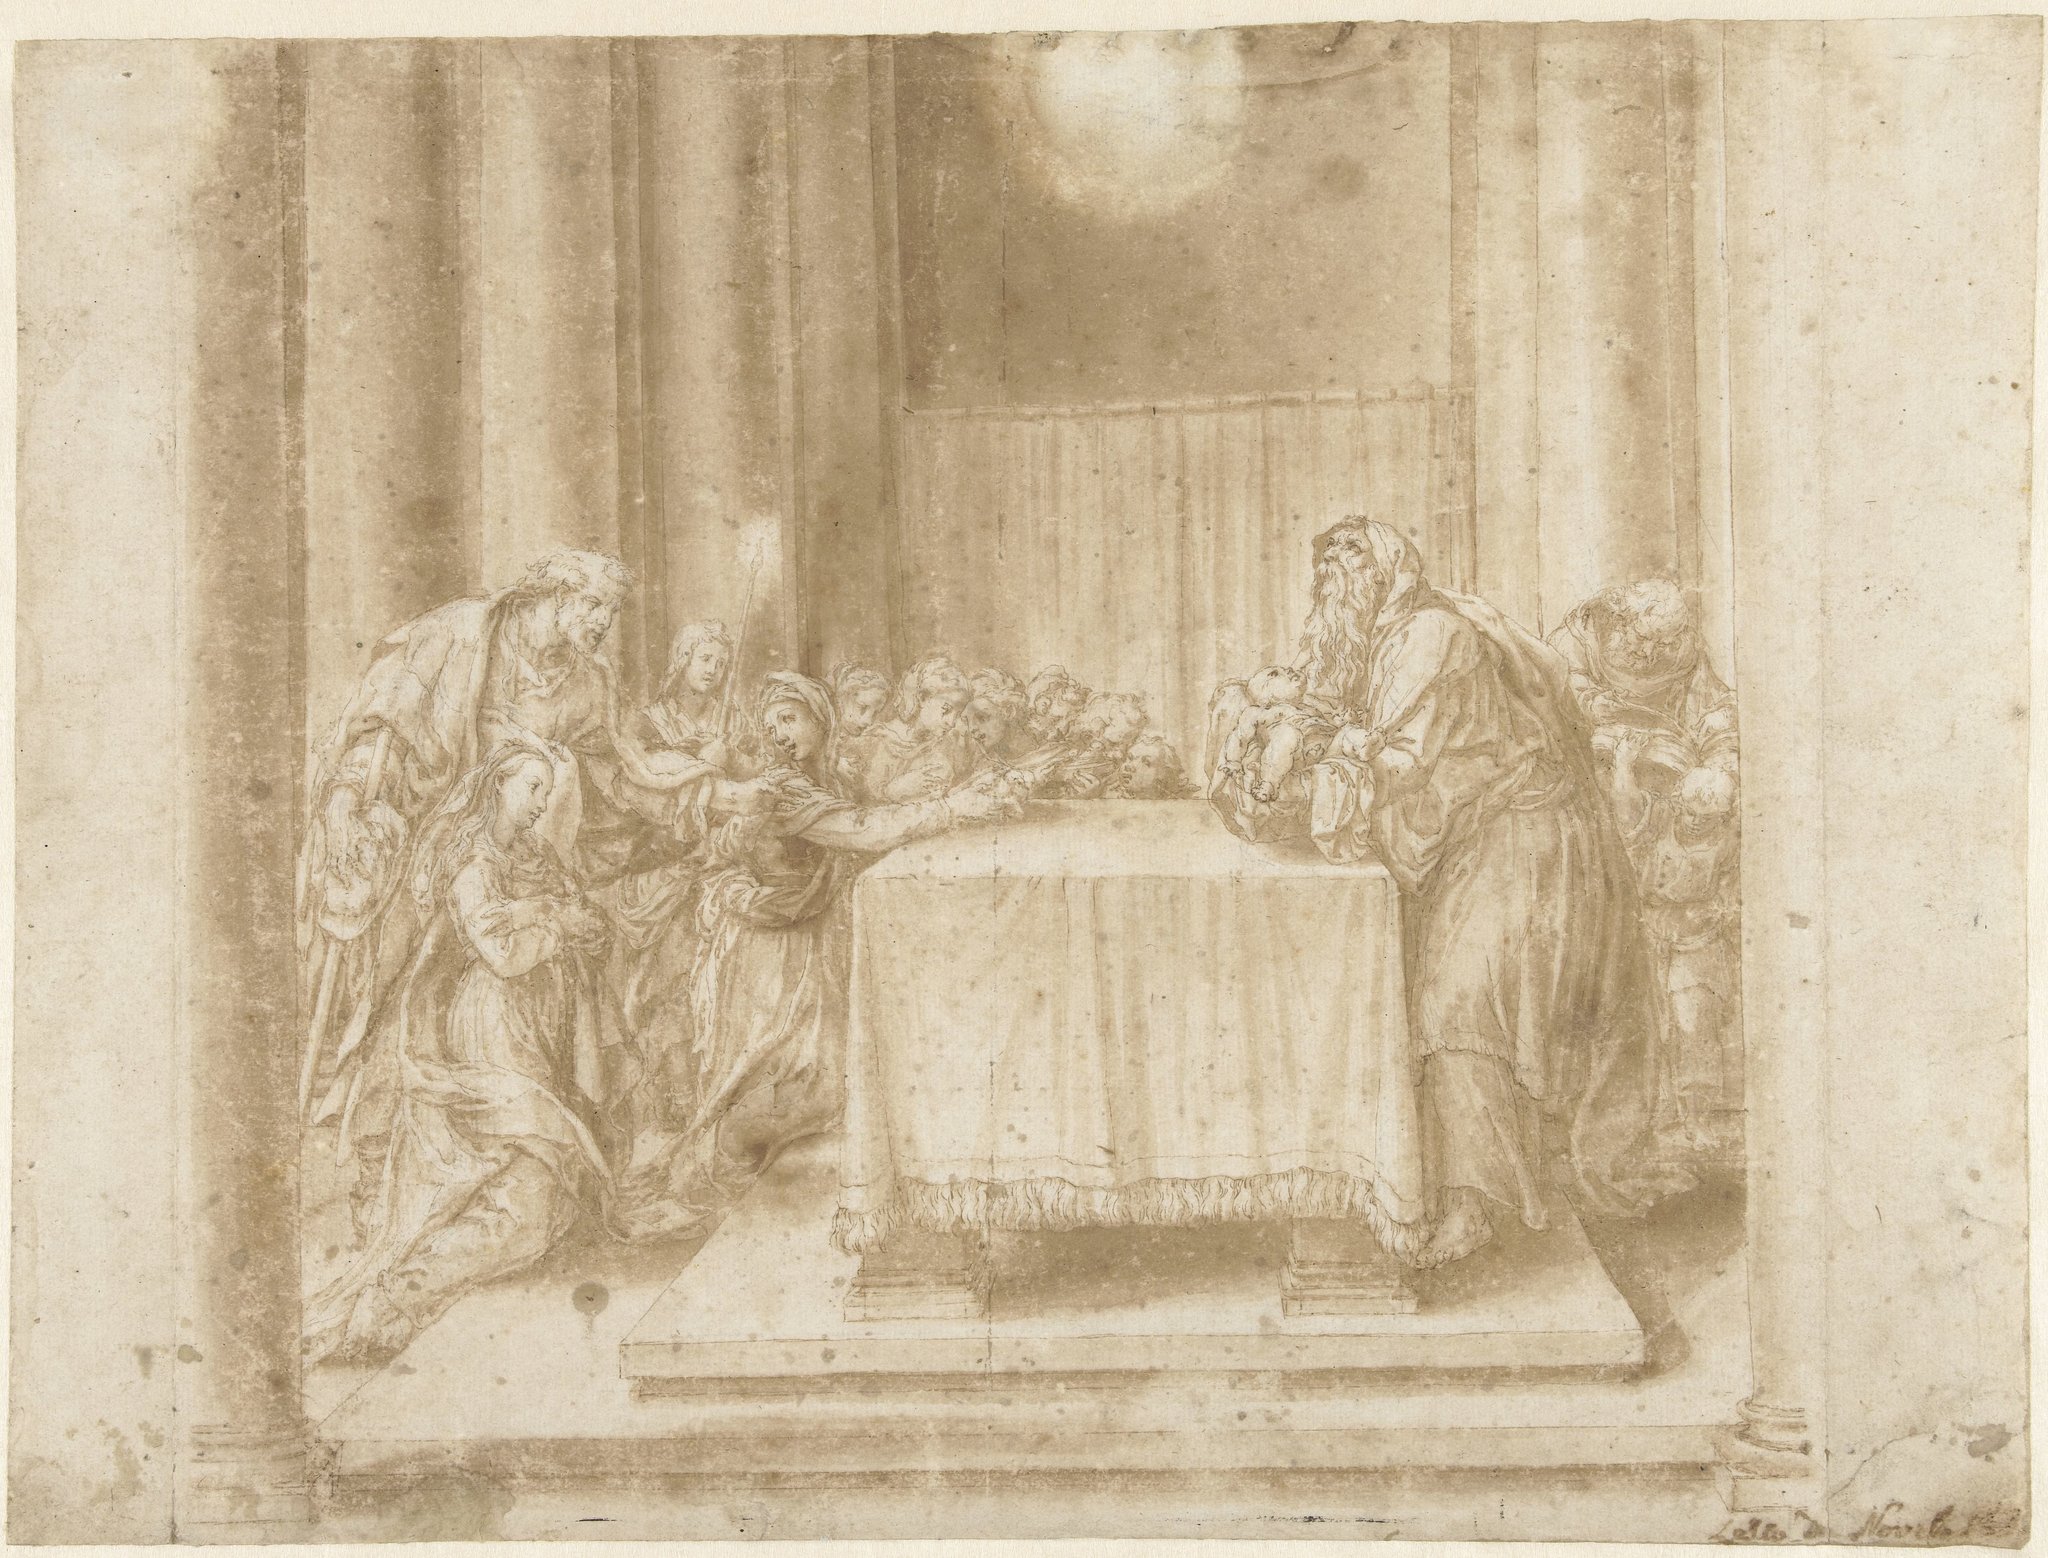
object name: drawing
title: De opdracht in de tempel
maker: lelio orsi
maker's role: draughtsman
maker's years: 1511-1587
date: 1521-1587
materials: ink, paper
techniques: brush, pen